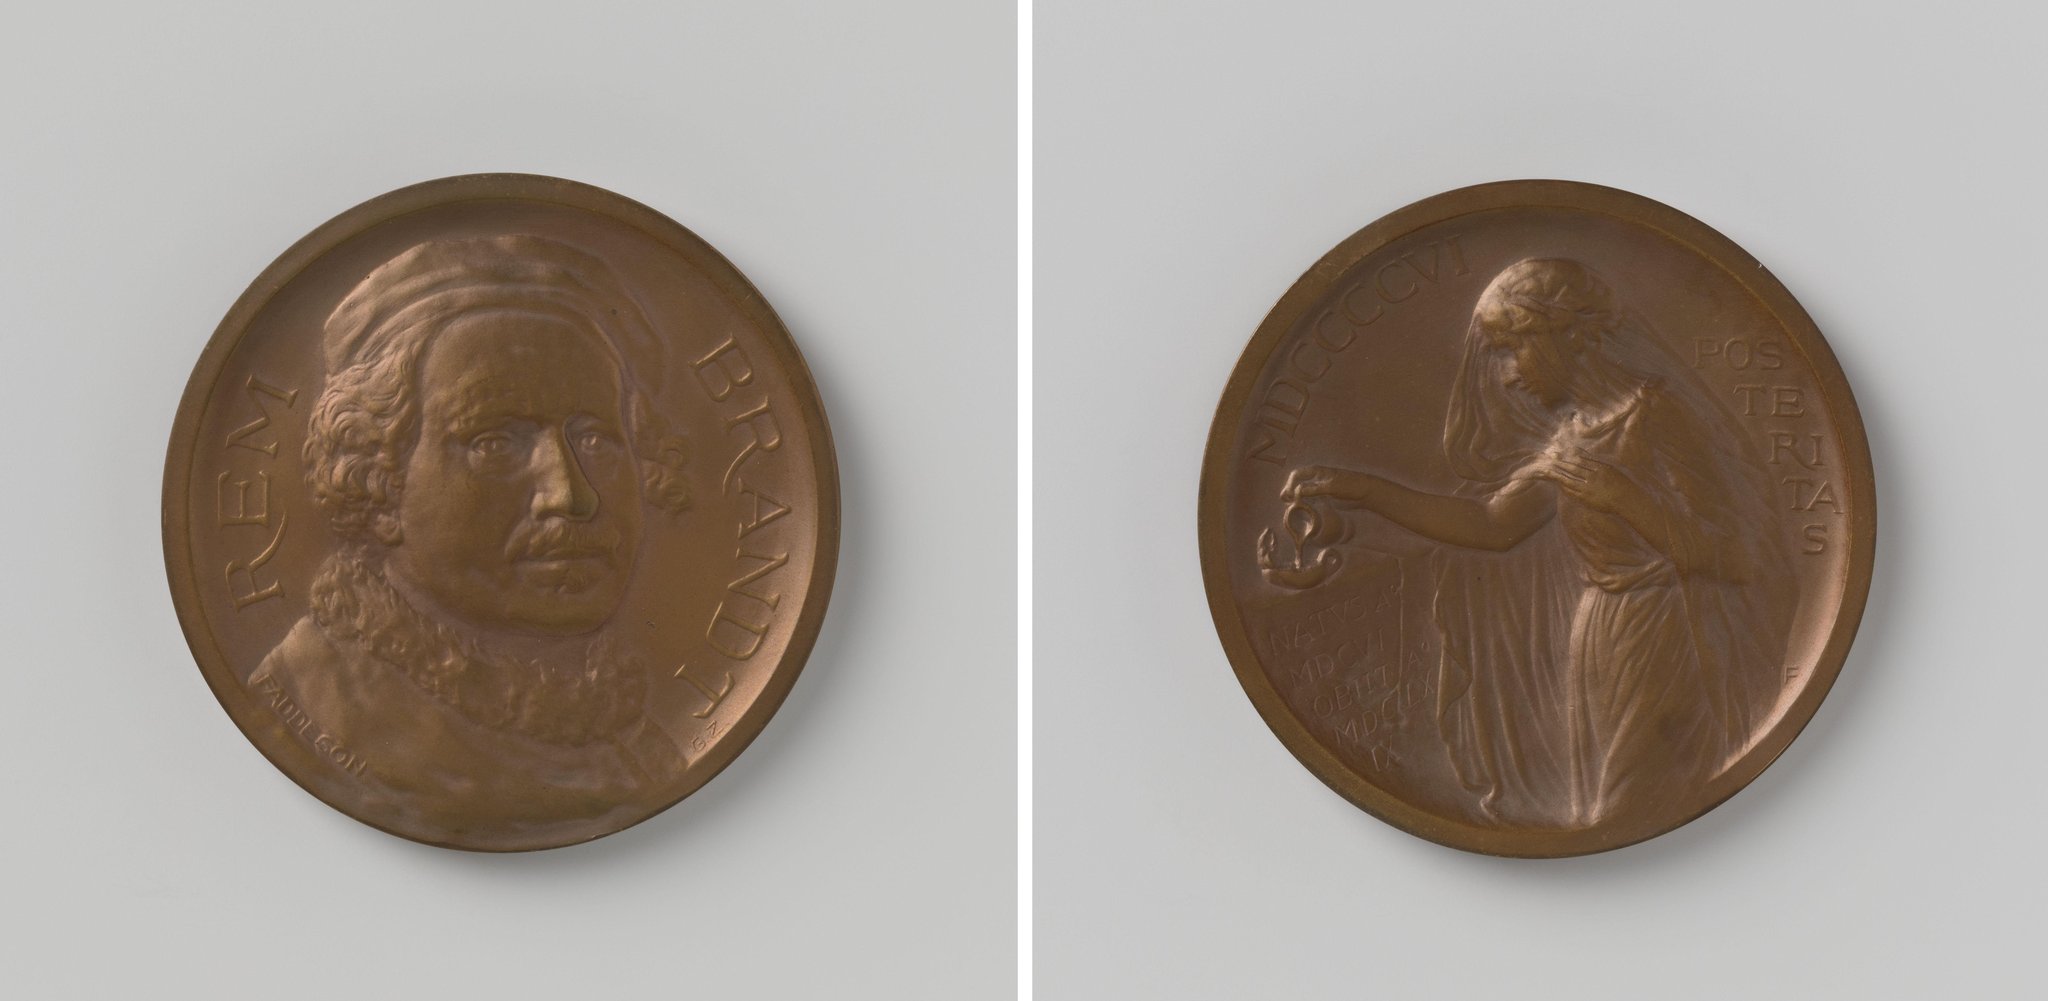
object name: history medal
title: Driehonderdjarige herdenking van de geboorte van Rembrandt van Rijn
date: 1906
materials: bronze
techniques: striking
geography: netherlands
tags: leiden, amsterdam, painter, print maker, rembrandt van rijn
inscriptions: : ‘REMBRANDT / FADDEGON’, : ‘MDCCCCVI, NATVS AoMDCVI OBIIT Ao MDCLXIX / POSTERITAS’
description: Bronzen penning. Voorzijde: borststuk Rembrandt met muts binnen omschrift. Keerzijde: gesluierde vrouw giet olie in brandend olielampje, staande op steen met opschrift; in veld rechts: opschrift.